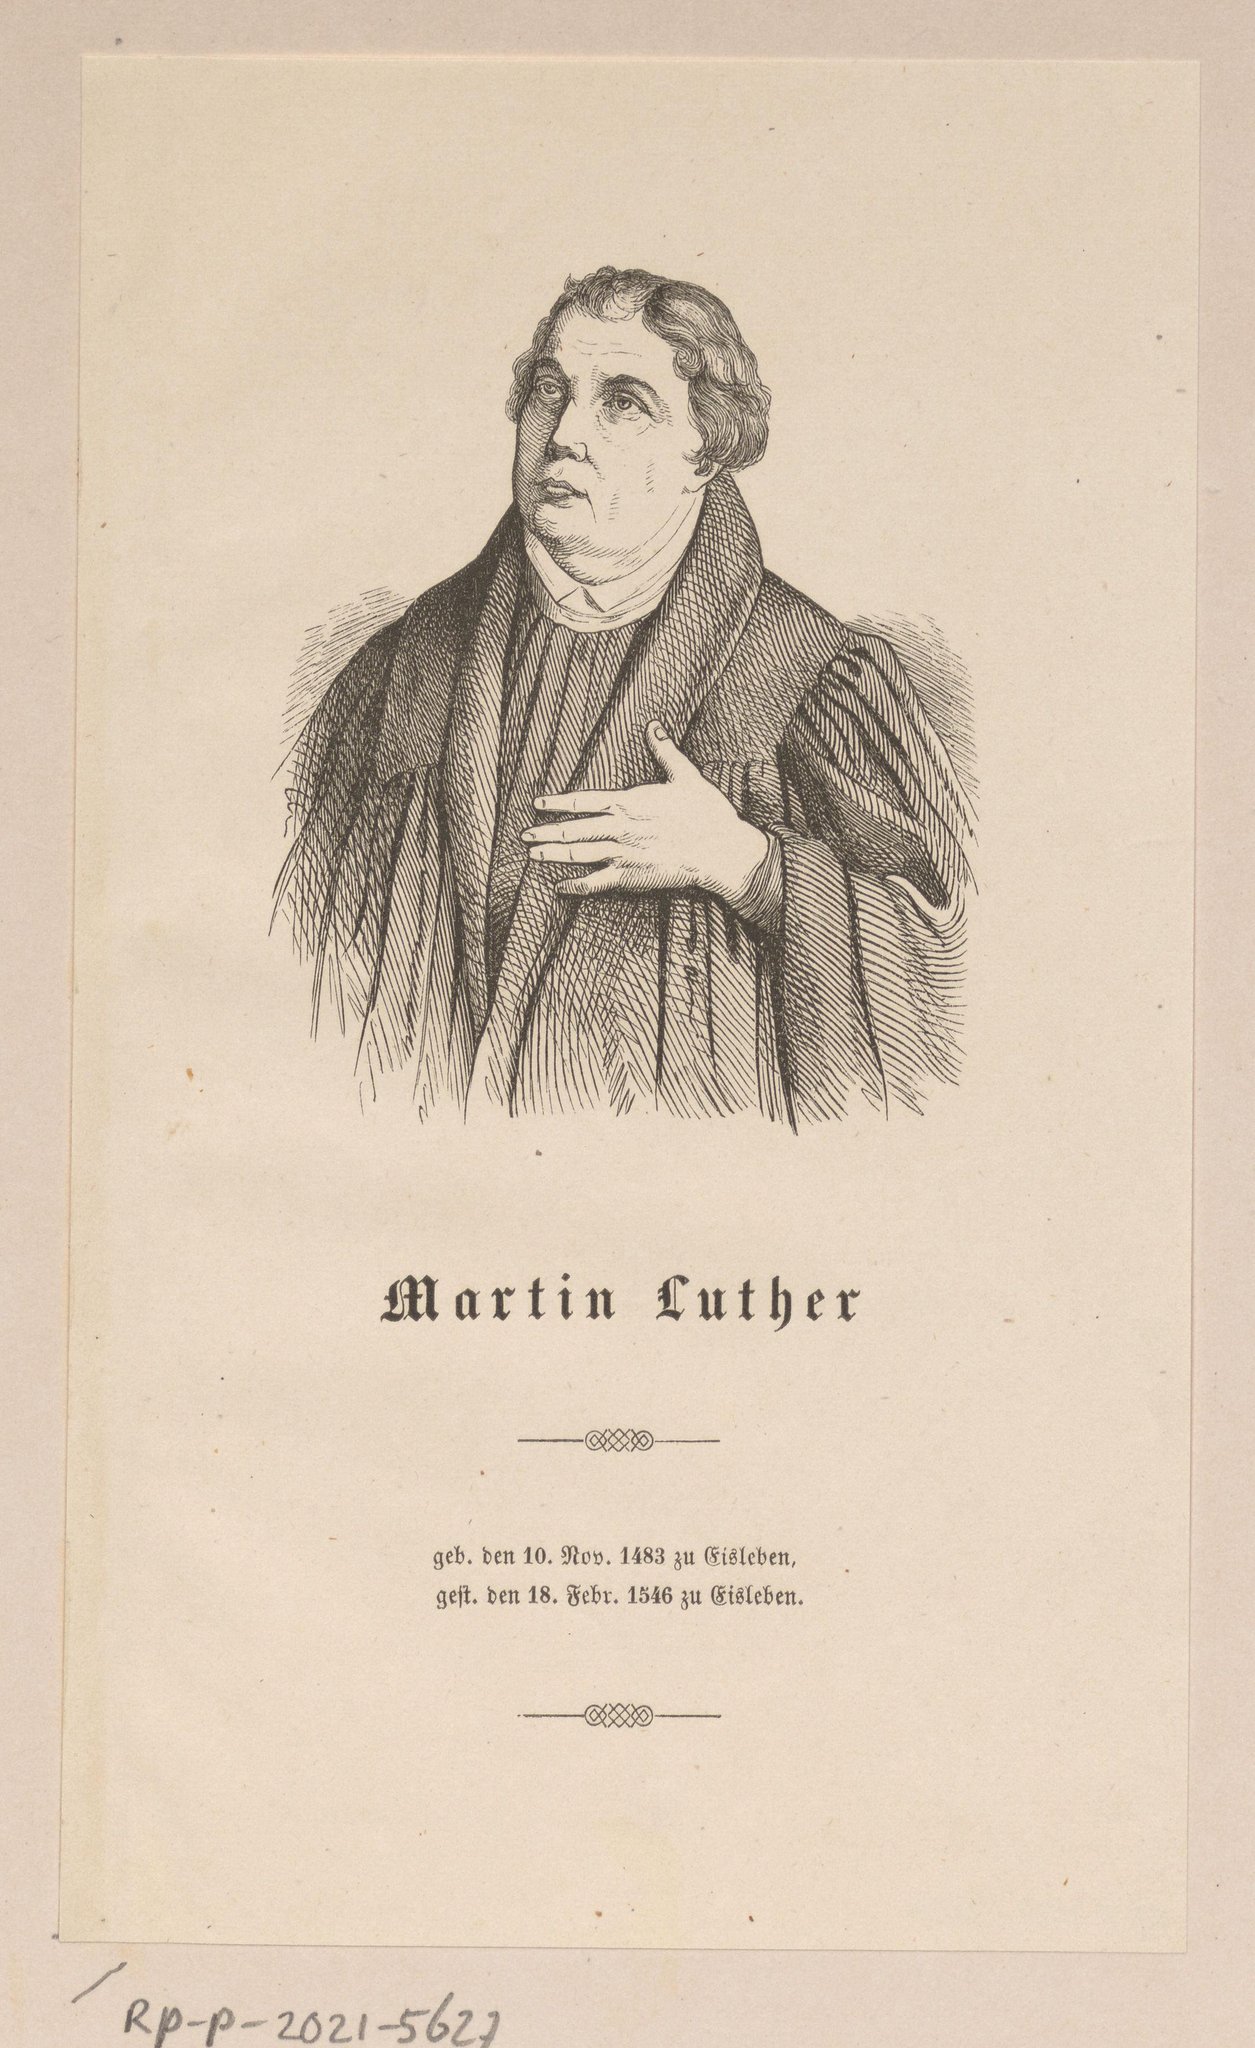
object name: print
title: Portret van Martin Luther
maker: Anonymous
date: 1854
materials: paper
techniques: letterpress printing, engraving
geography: germany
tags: priest, martin luther, theologian, historical persons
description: Prent waarschijnlijk uit: Scherr, Johannes. Geschichte der deutschen Literatur. Leipzig: Otto Wigand, 1854.